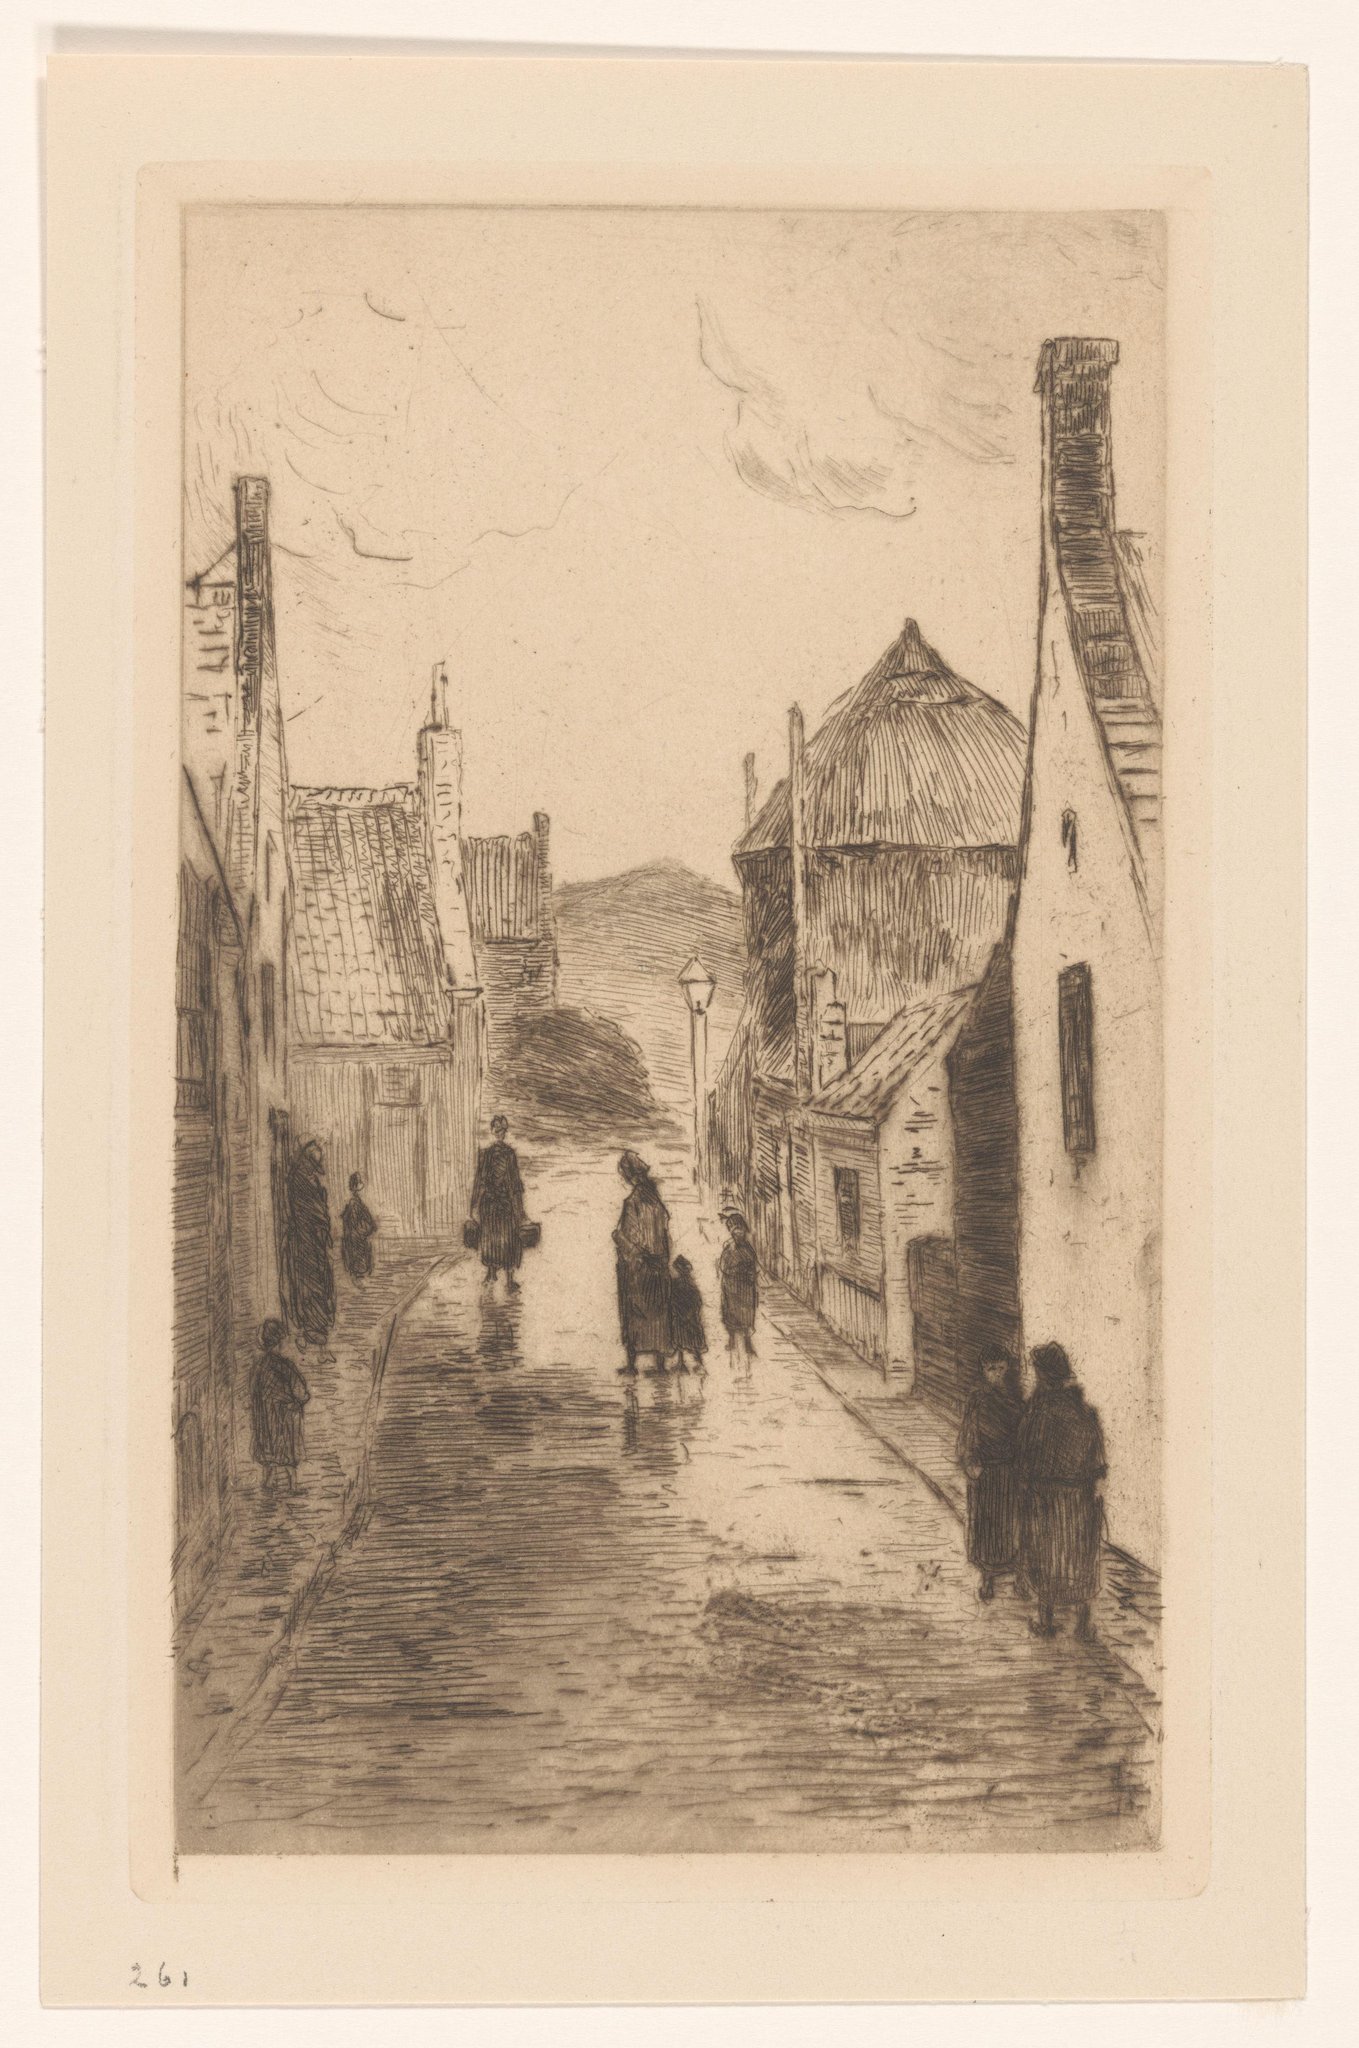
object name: print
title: Straatgezicht in Katwijk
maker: carel nicolaas storm van s-gravesande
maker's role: draughtsman, print maker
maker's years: 1841-1924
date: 1887-1889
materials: paper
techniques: drypoint, etching, intaglio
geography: netherlands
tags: hay-stack, street (+ city(-scape) with figures, staffage)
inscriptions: collector's mark: Lugt 2228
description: Mensen met kinderen lopen door een straat in Katwijk. Rechts een hooiberg.